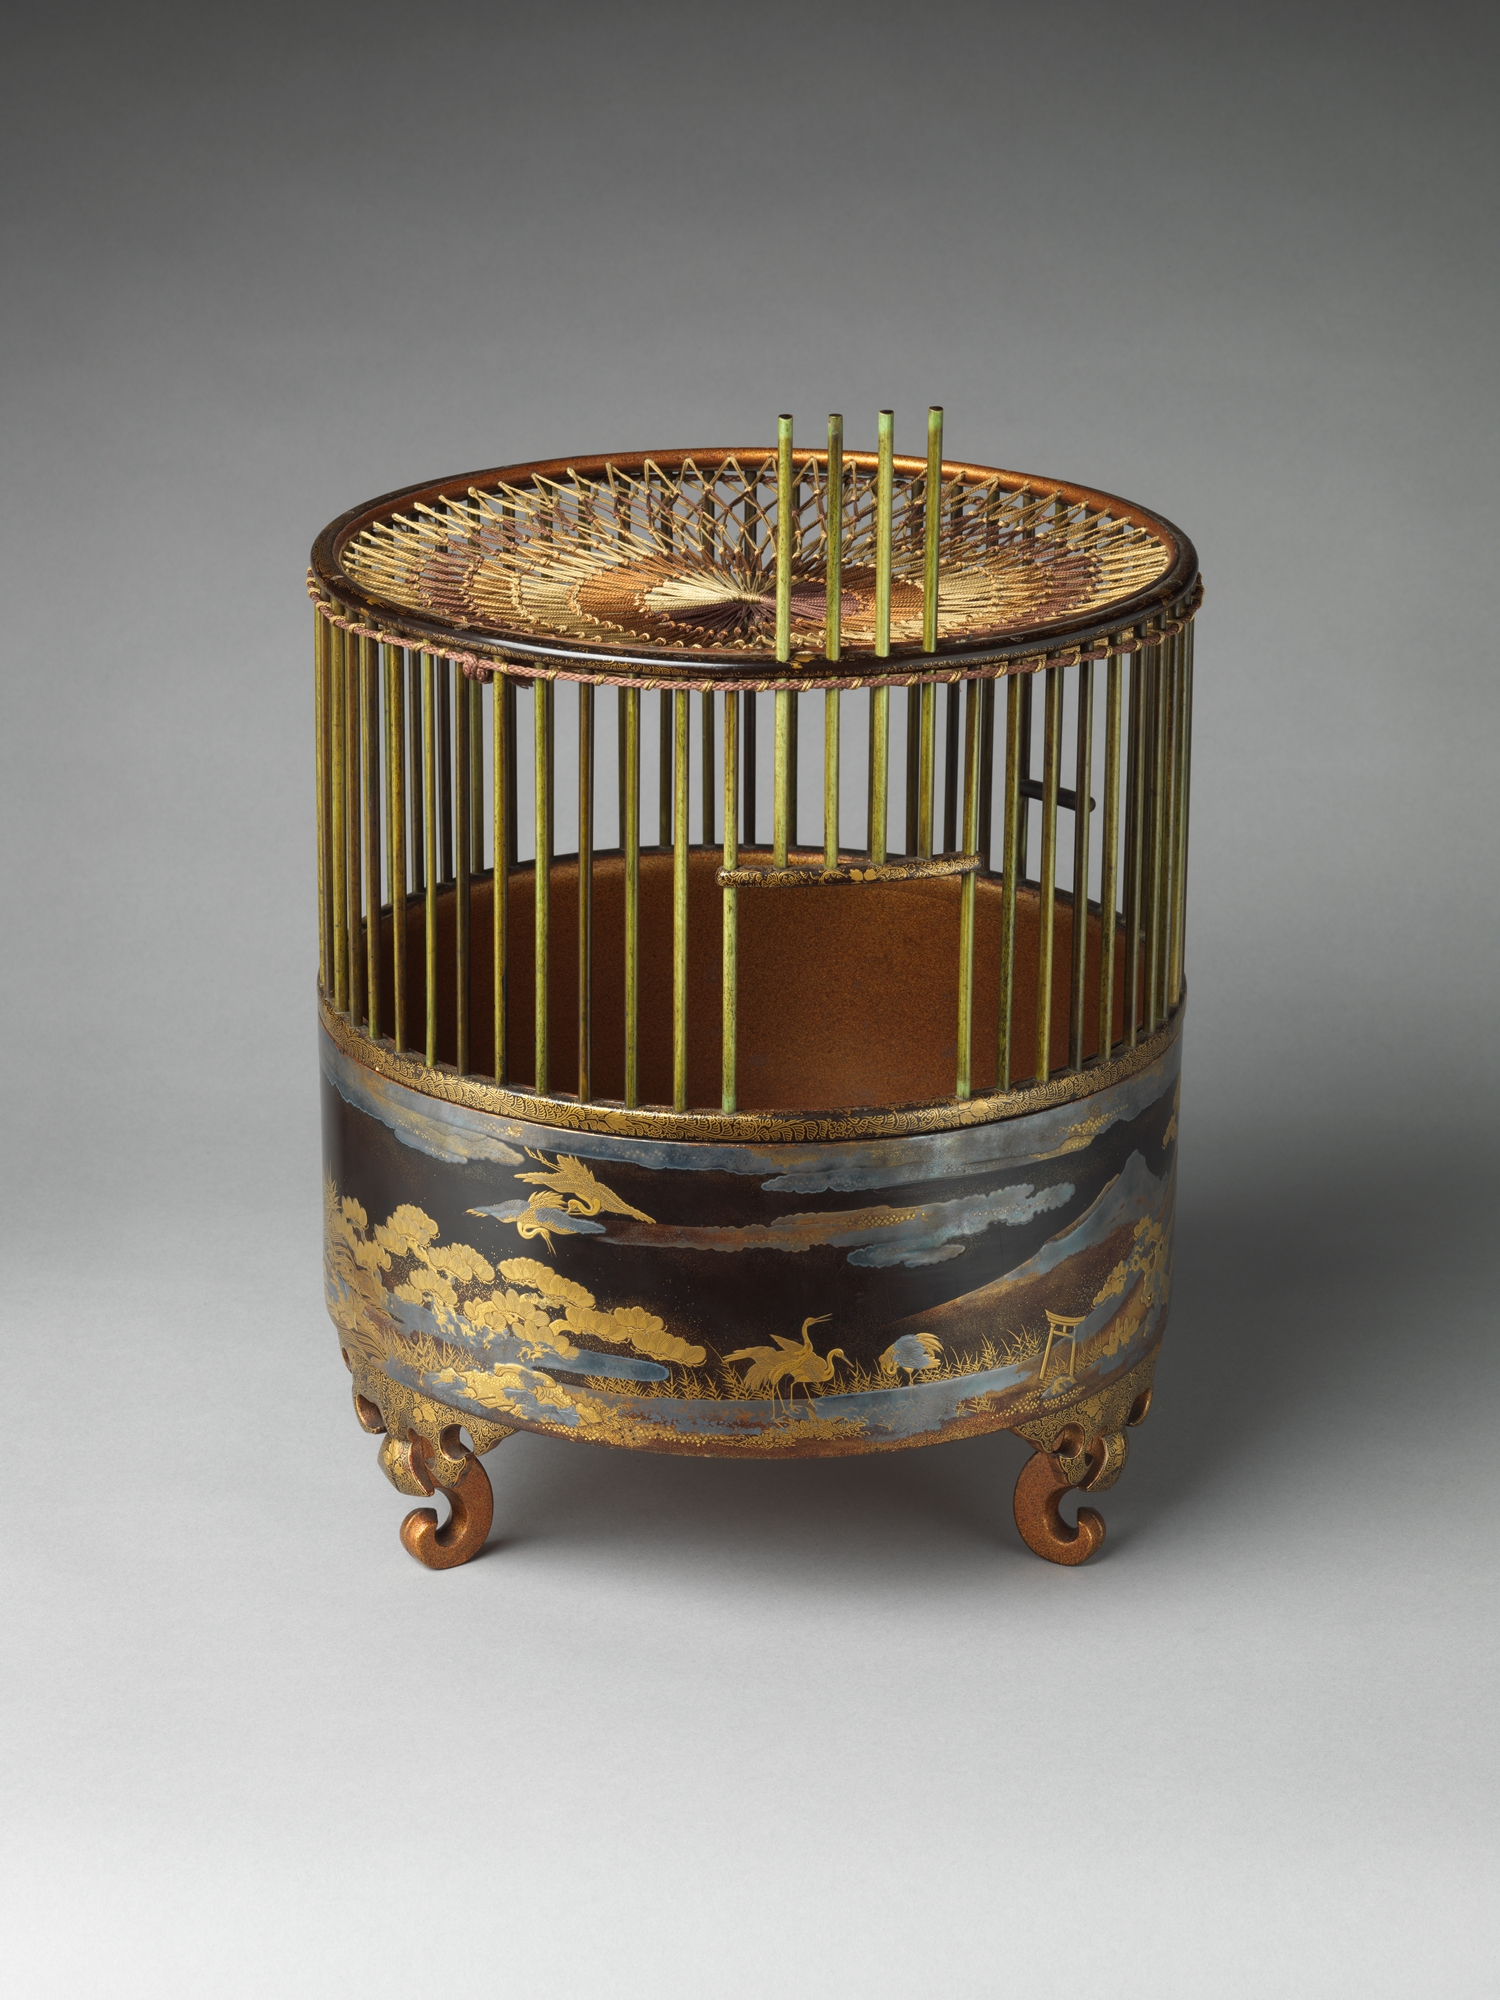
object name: birdcage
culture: japanese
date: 1701-1800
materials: gold, lacquer, silk, silver, wood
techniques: dyeing, maki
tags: cranes,mountains,trees,clouds